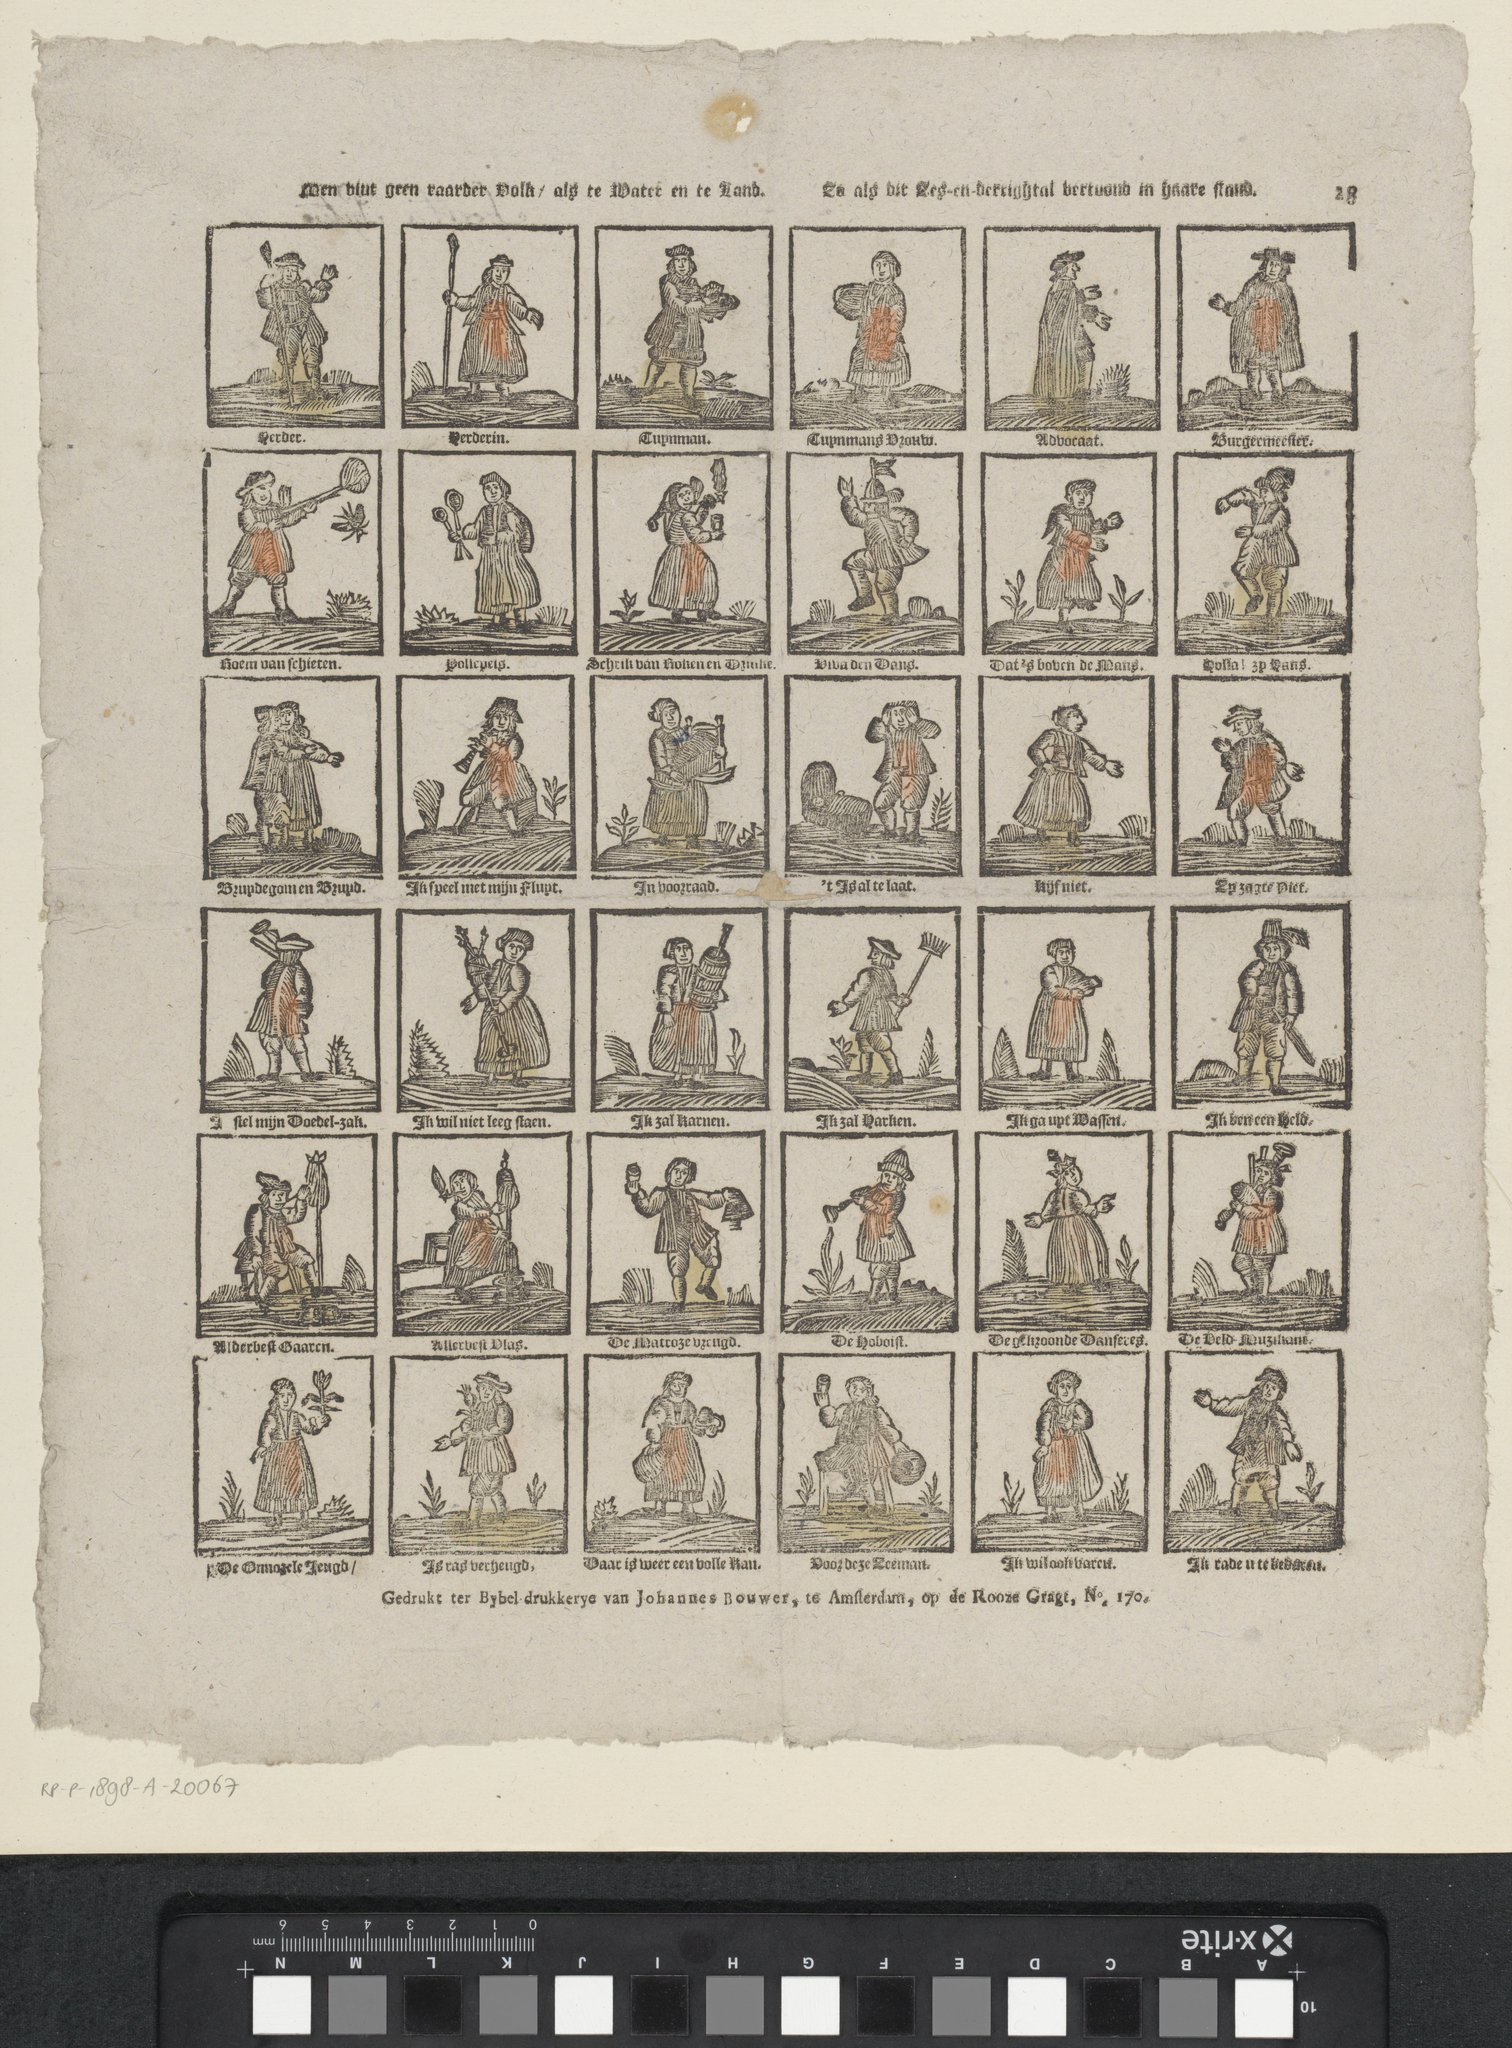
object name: print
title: Men vint geen raarder volk / Als te water en te land. / Zo als dit zes-en-dertigtal vertoond in haare stand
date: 1805-1808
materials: paper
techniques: colour, letterpress printing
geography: amsterdam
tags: musician, human types, herding, herdsman, herdswoman, shepherd, shepherdess, cowherd, etc., farmers, seaman: sailor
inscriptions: collector's mark: Lugt 2228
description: Blad met 36 voorstellingen van verschillende figuren en bezigheden. Onder elke afbeelding een onderschrift. Genummerd rechtsboven: 28.